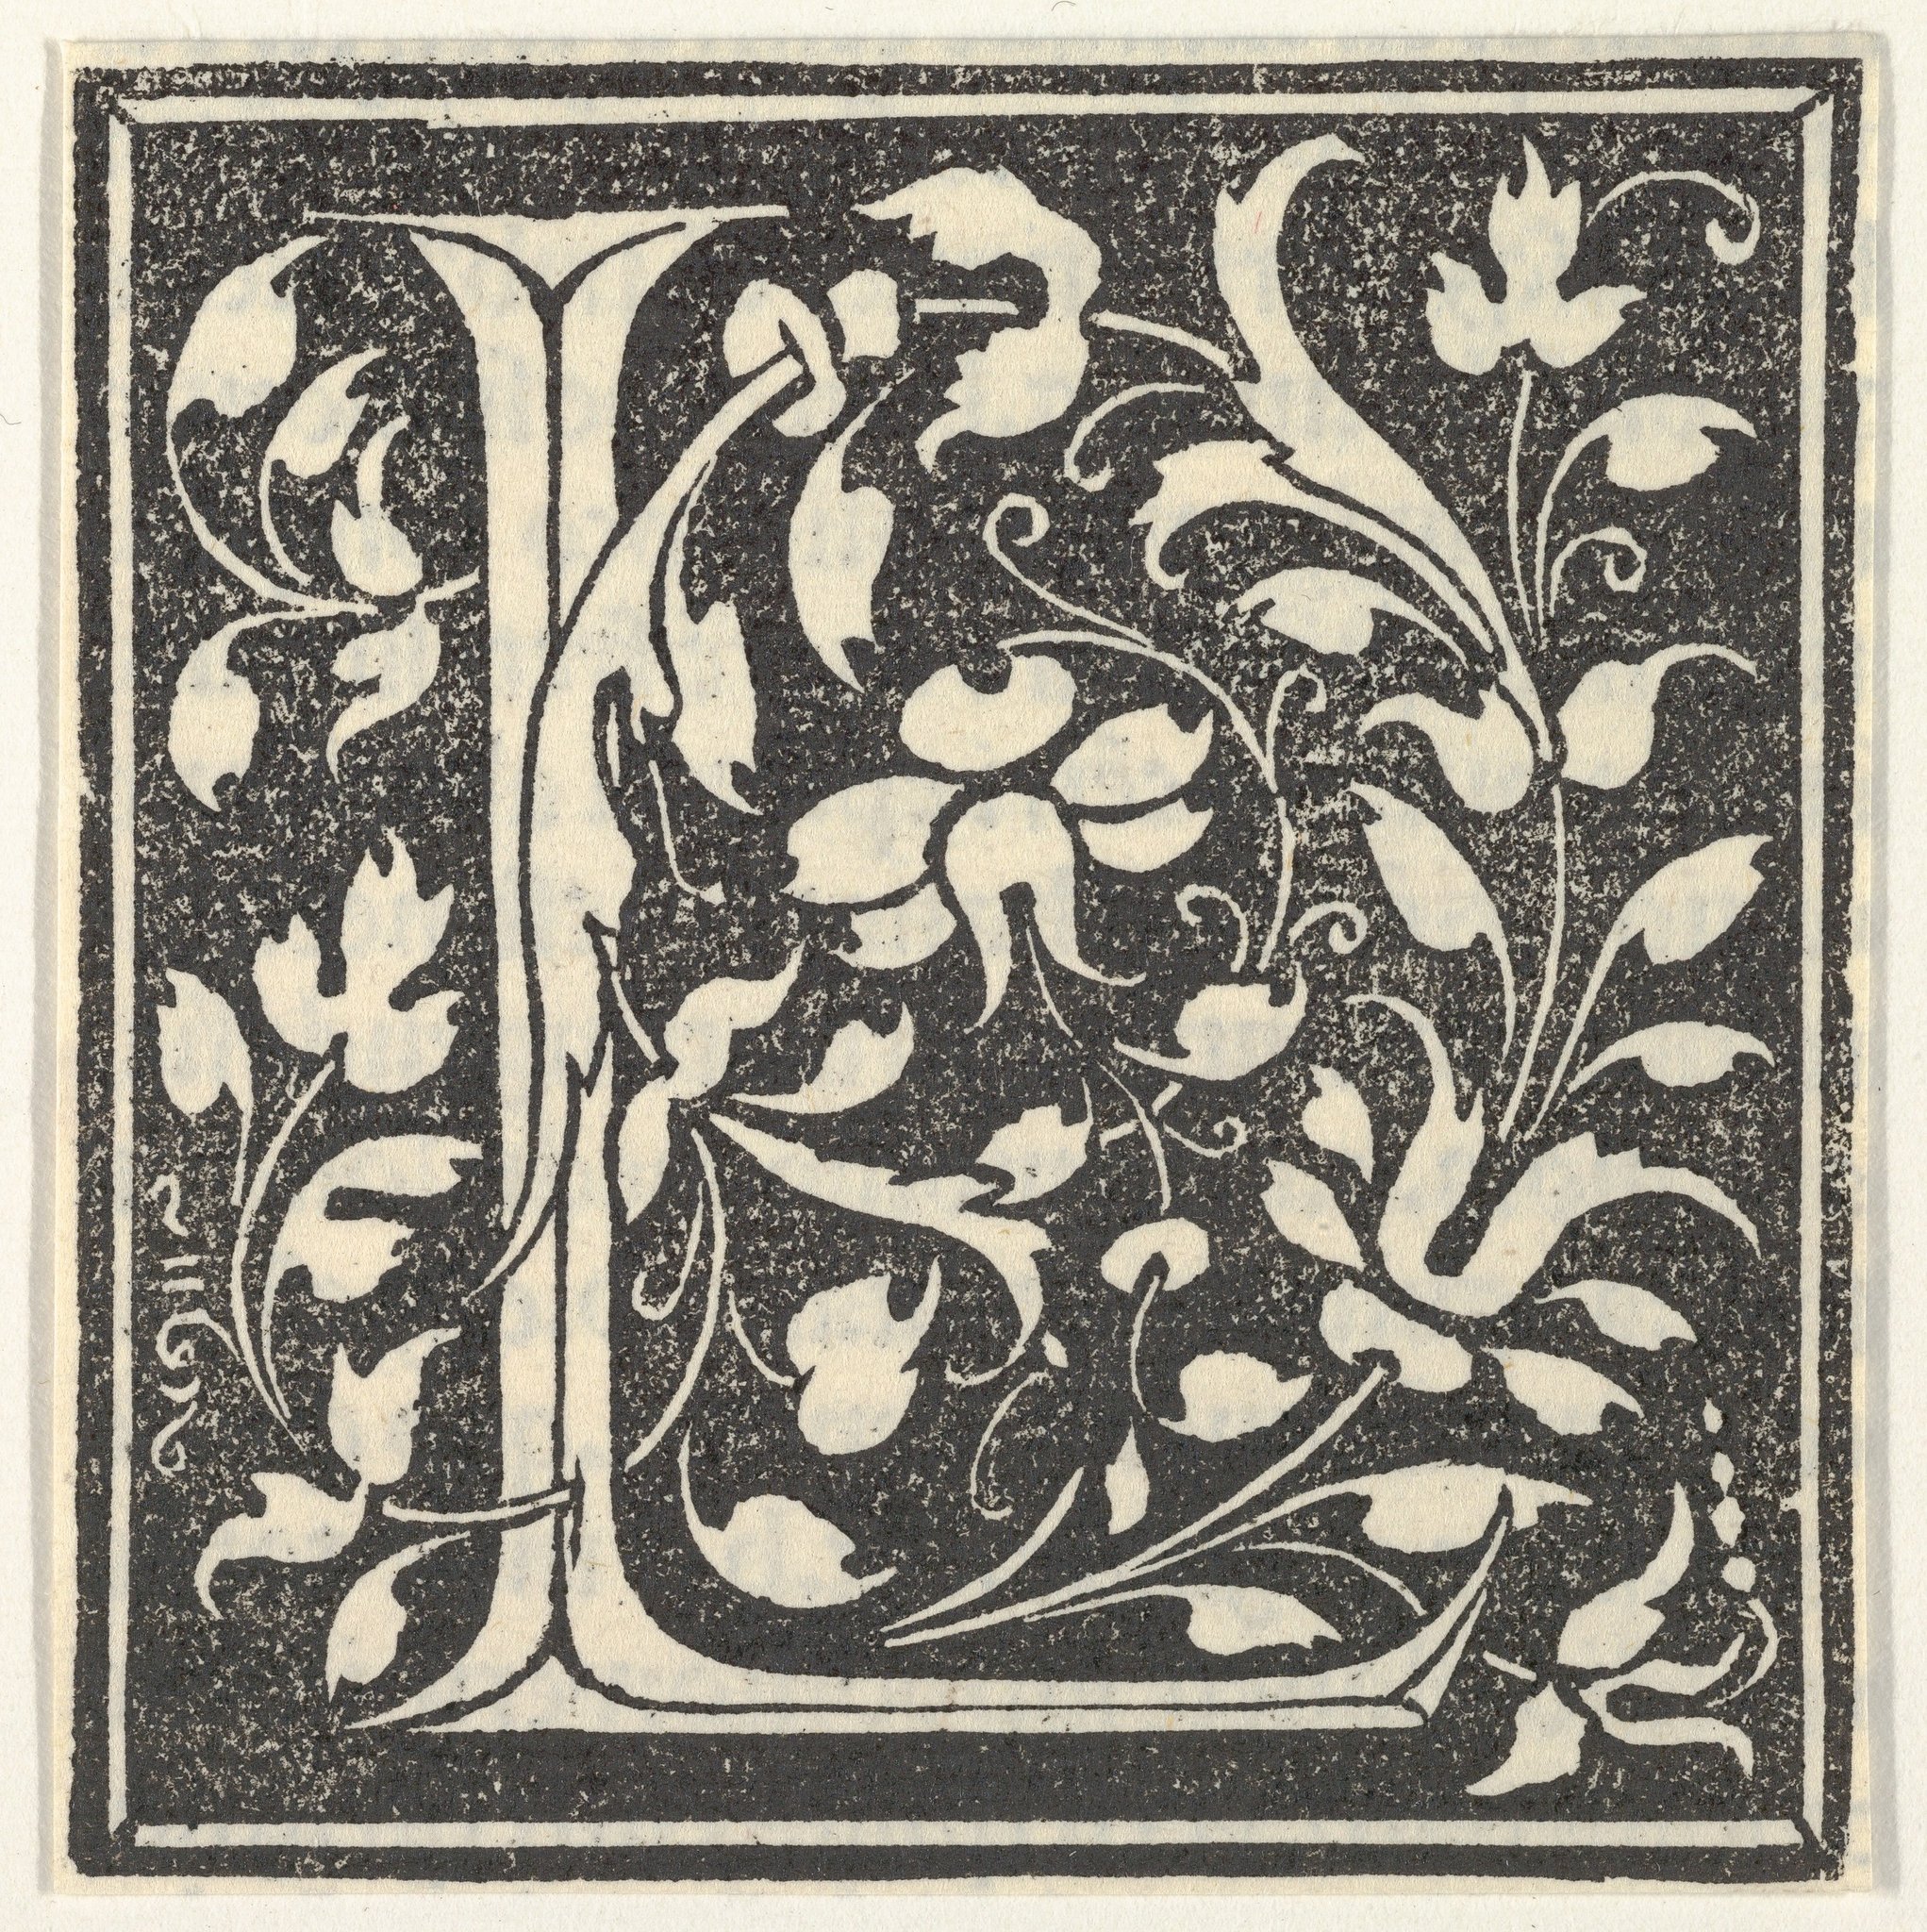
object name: print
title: Initial letter L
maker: anonymous, italian, 15th century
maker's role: artist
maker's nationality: italian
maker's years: 1400-1500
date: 1495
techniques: woodcut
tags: leaves